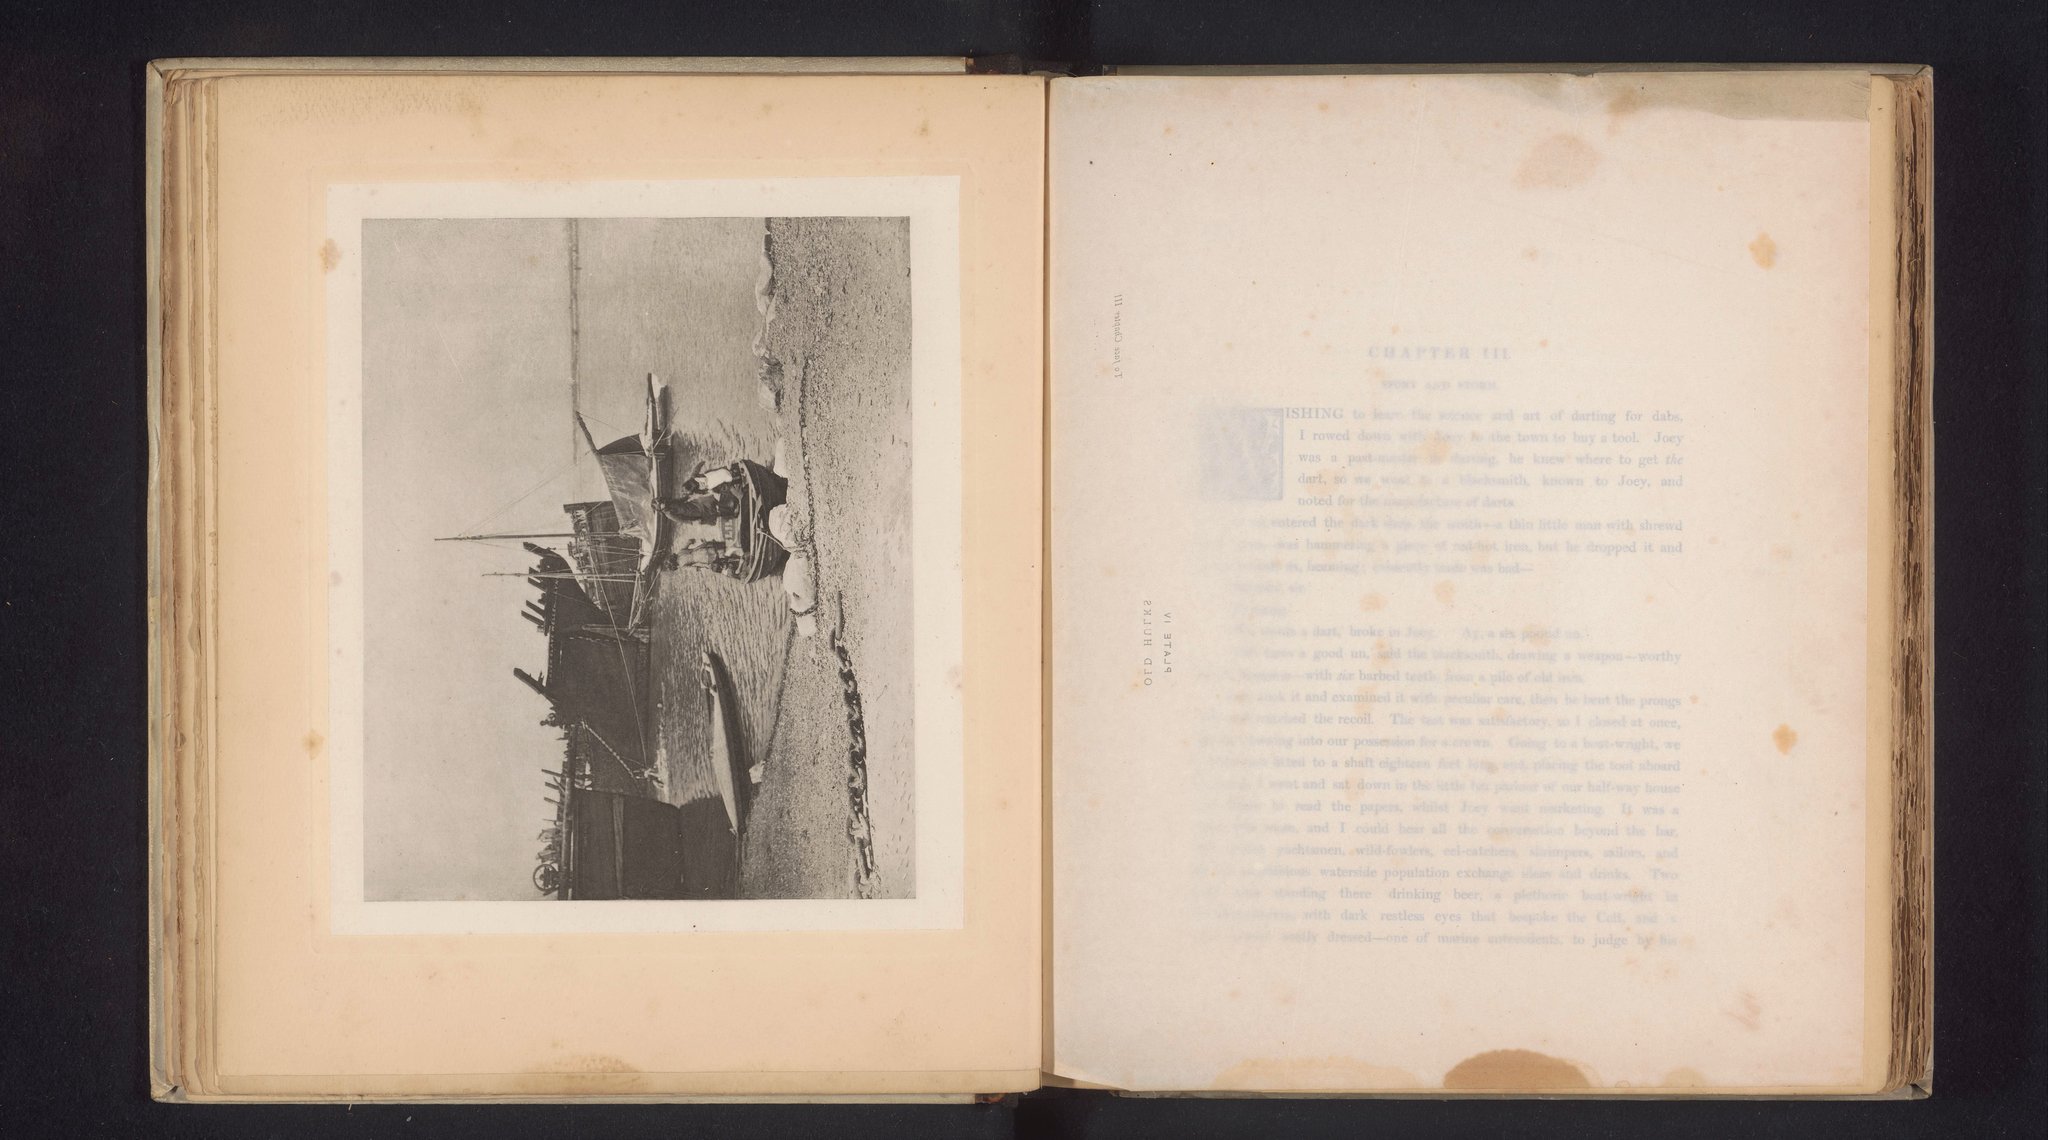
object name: photomechanical print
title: Kinderen in een roeiboot op de Breydon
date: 1880-1890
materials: paper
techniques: photoaquatint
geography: breydon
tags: child, ships (in general), rowing-boat, canoe, etc.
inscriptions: number: ‘Plate IV’, title: ‘Old hulks’